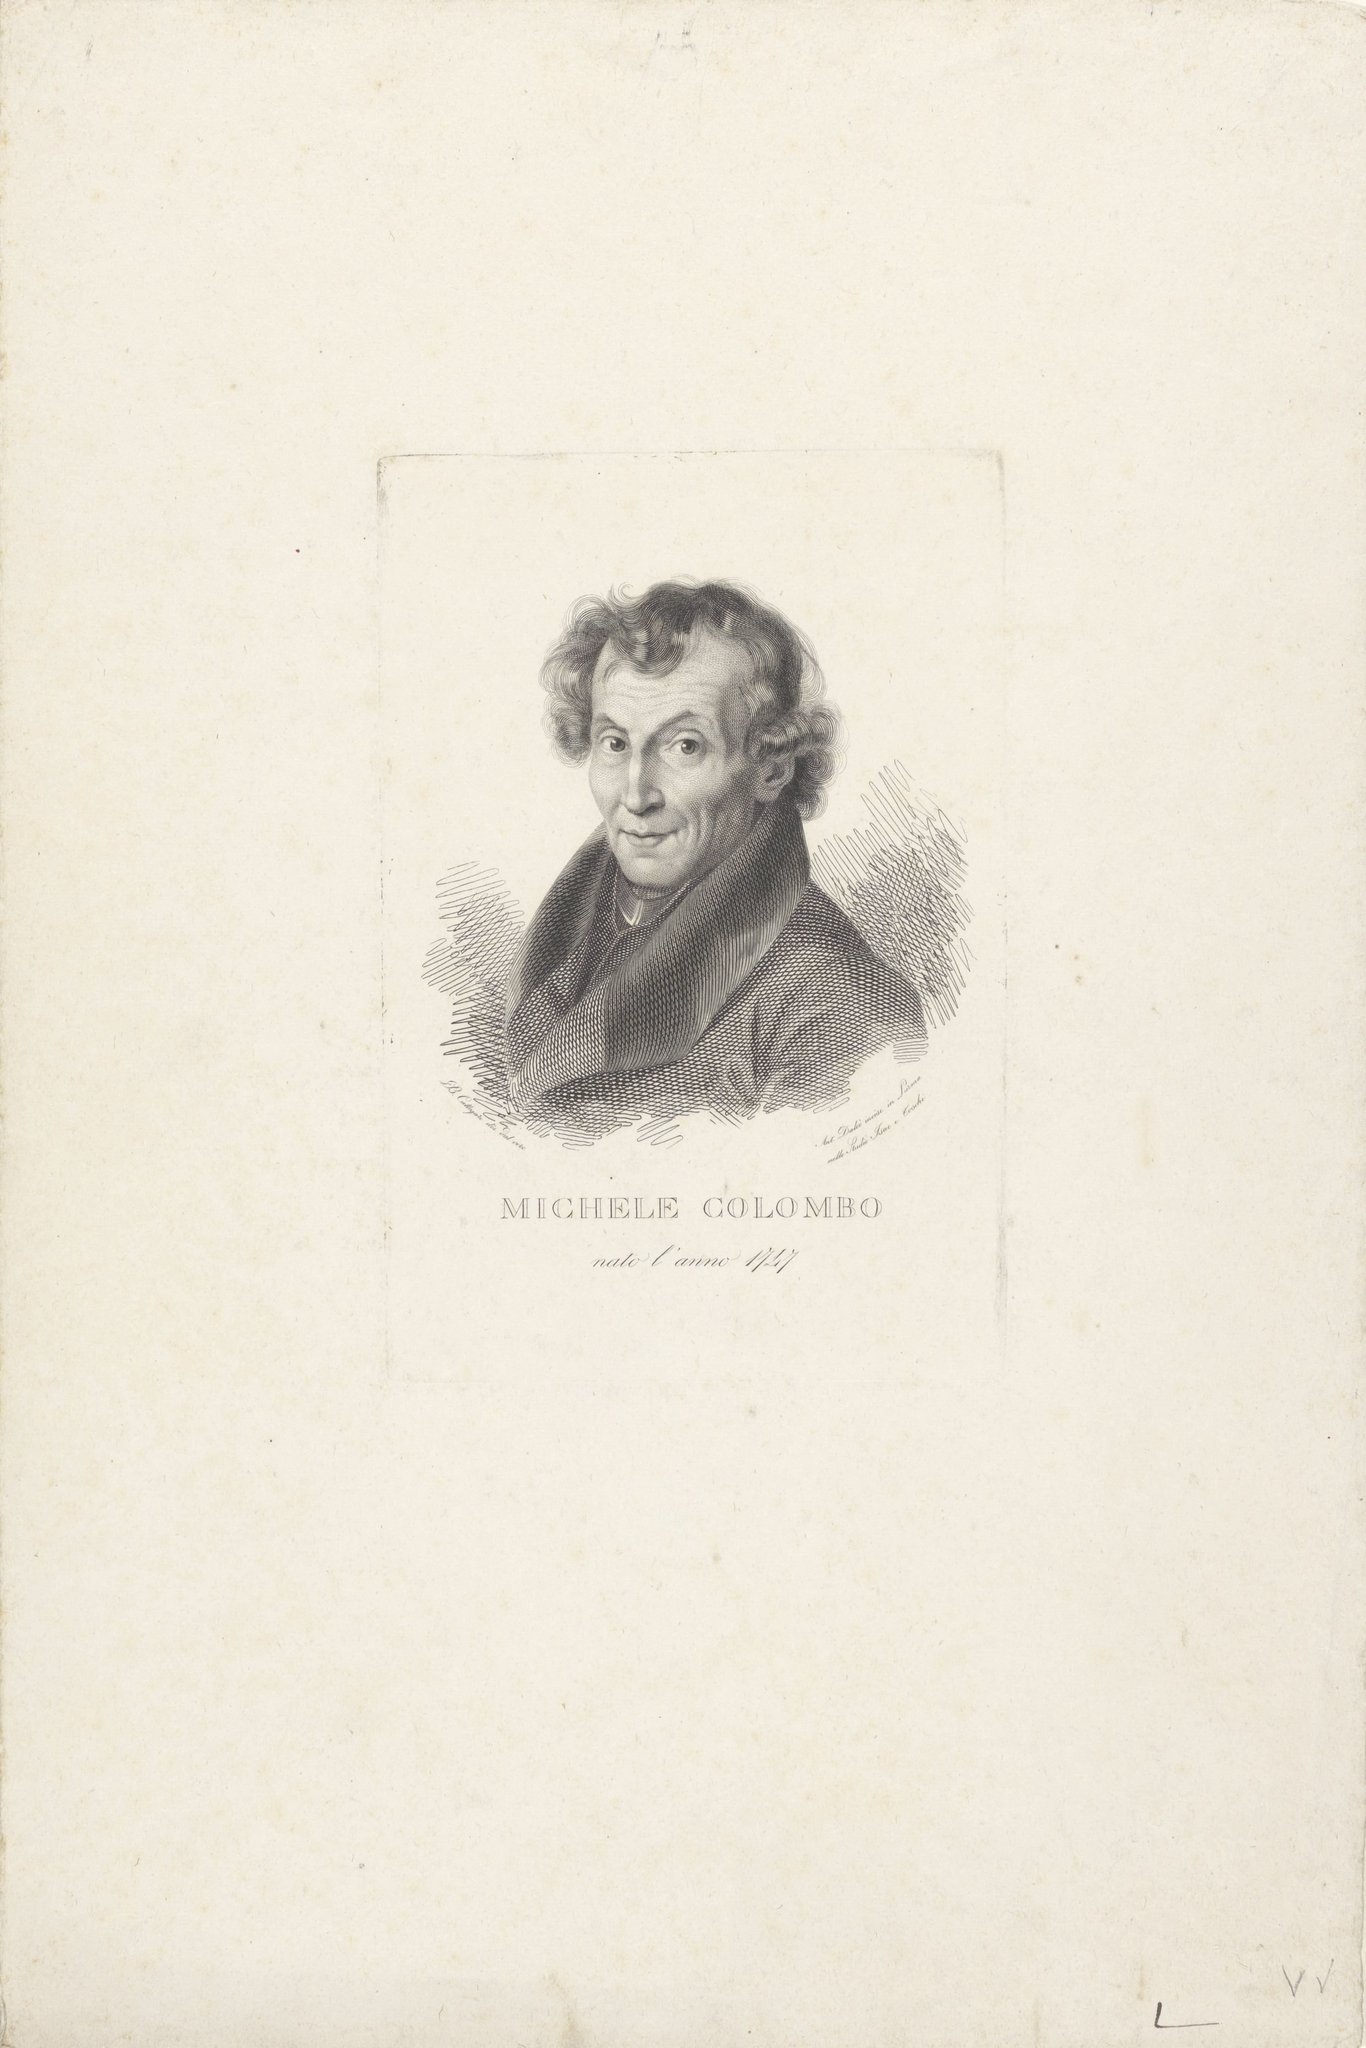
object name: print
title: Portret van Michele Colombo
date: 1812-1888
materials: paper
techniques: engraving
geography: italy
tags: historical persons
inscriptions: collector's mark: Lugt 2228